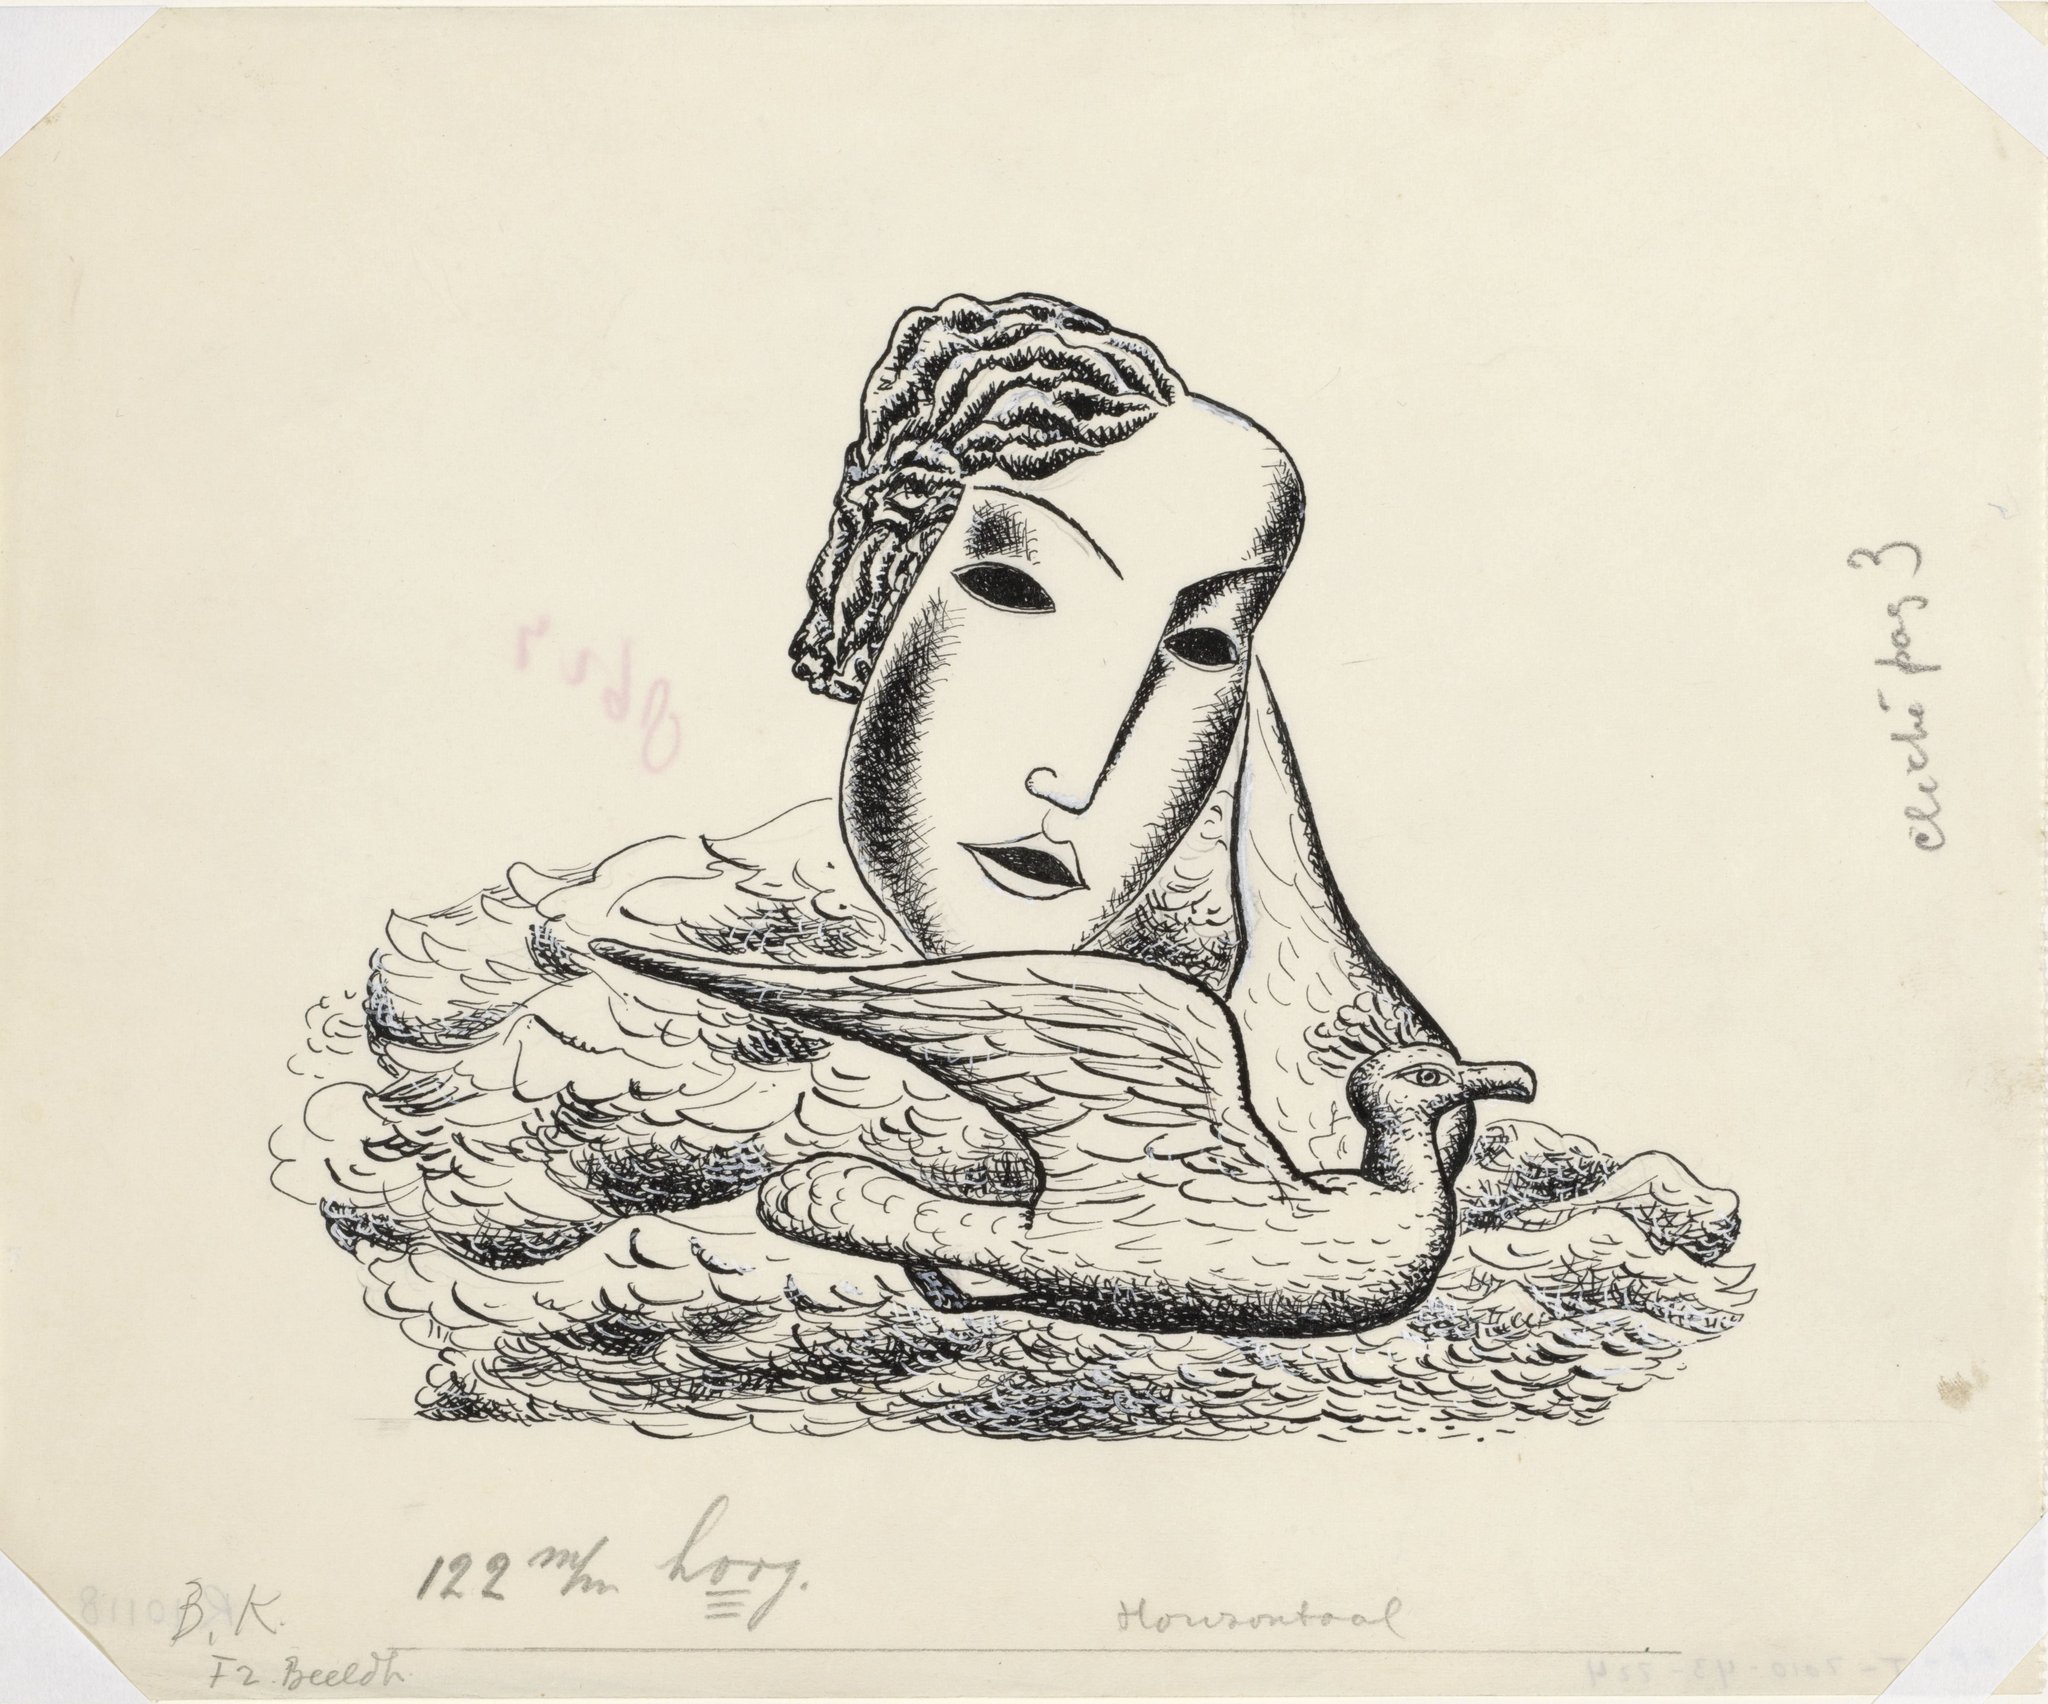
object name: drawing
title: Zonder titel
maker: leo gestel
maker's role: draughtsman, print maker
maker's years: 1881-1941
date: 1935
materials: gouache, ink, paper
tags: birds, head (human) - aa - female human figure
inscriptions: inscription: ‘cliché pag 3’, inscription: ‘B.K. // in F2 Beeldh.’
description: Midden boven maskerachtige vrouwenkop, rechtsonder klapwiekende vogel boven zee.